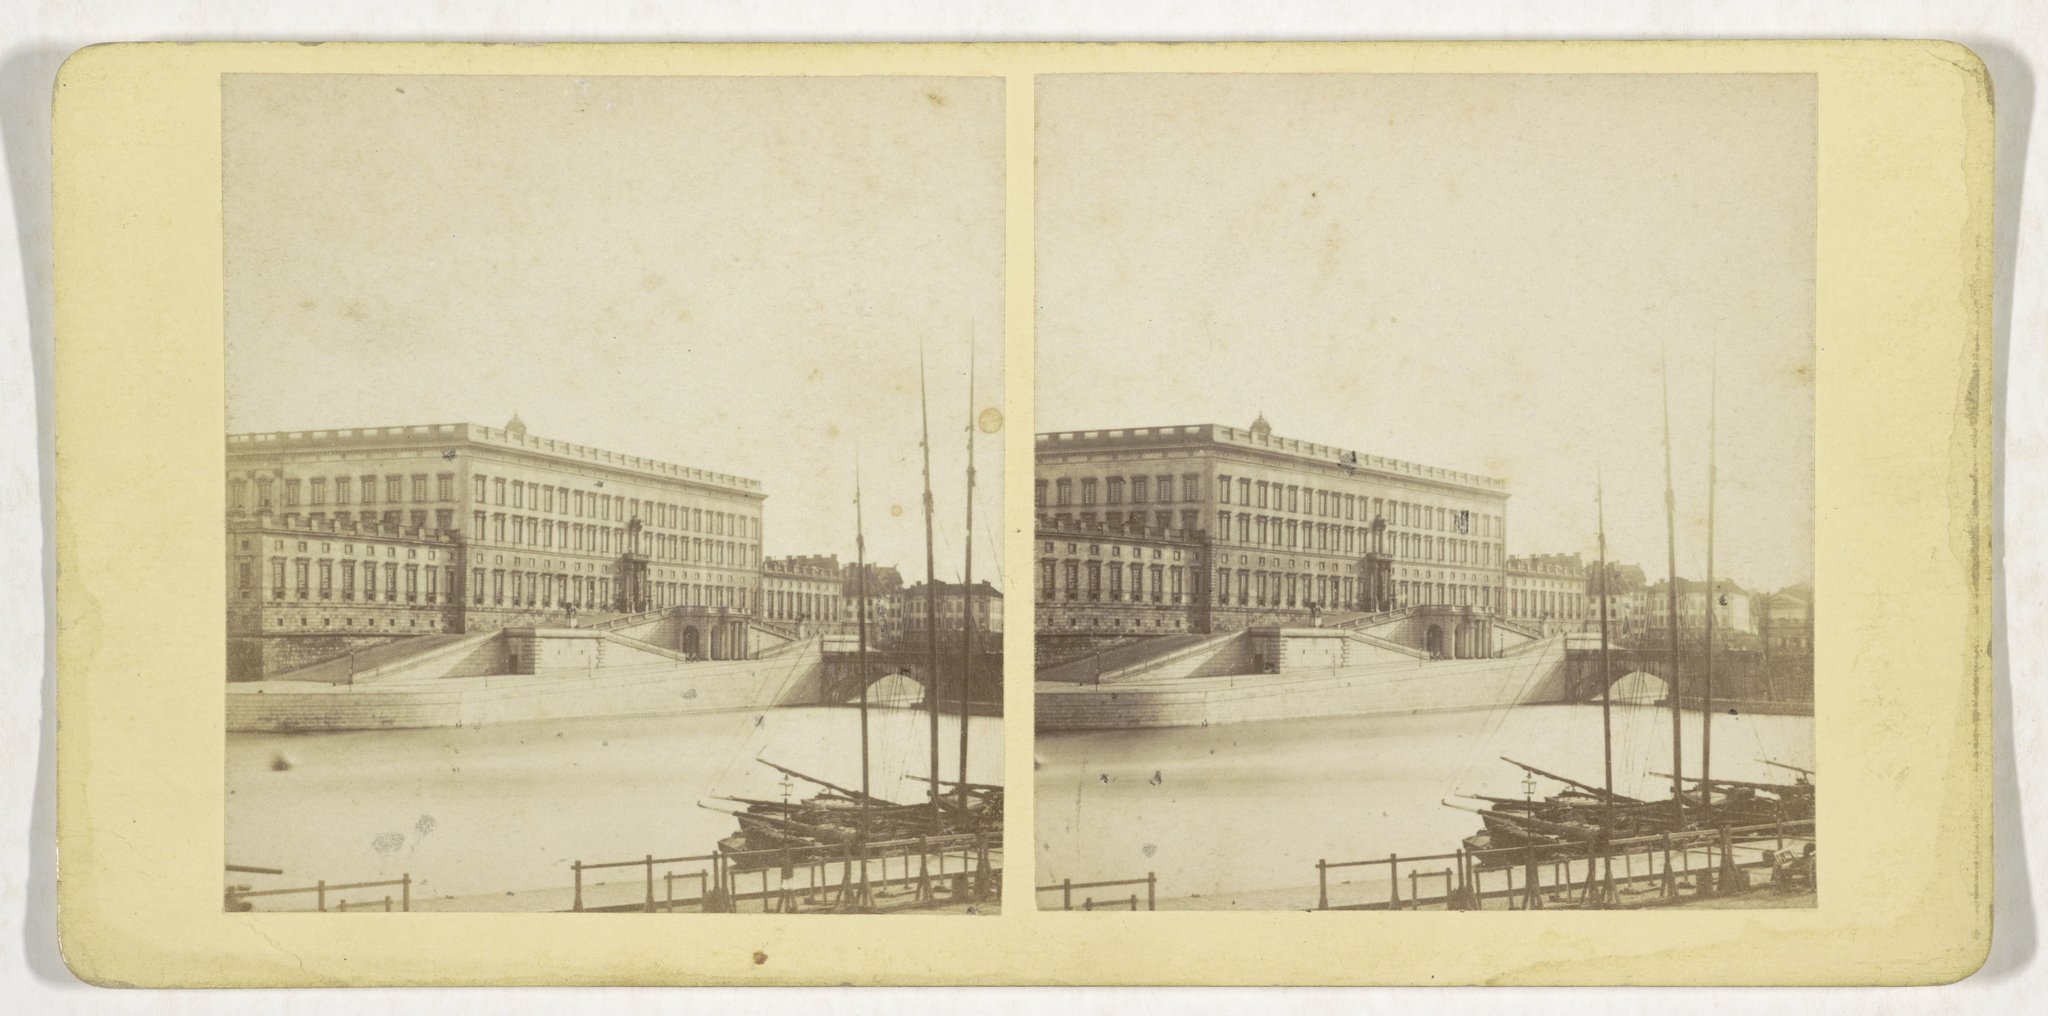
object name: stereograph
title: Stockholm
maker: Anonymous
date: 1868-1890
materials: cardboard, paper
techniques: albumen print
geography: stockholm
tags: palace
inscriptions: inscription: ‘Gezigt op het paleis van de rivier gezien Stockholm’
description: Het Koninklijk Paleis in Stockholm, gezien vanuit het noorden.